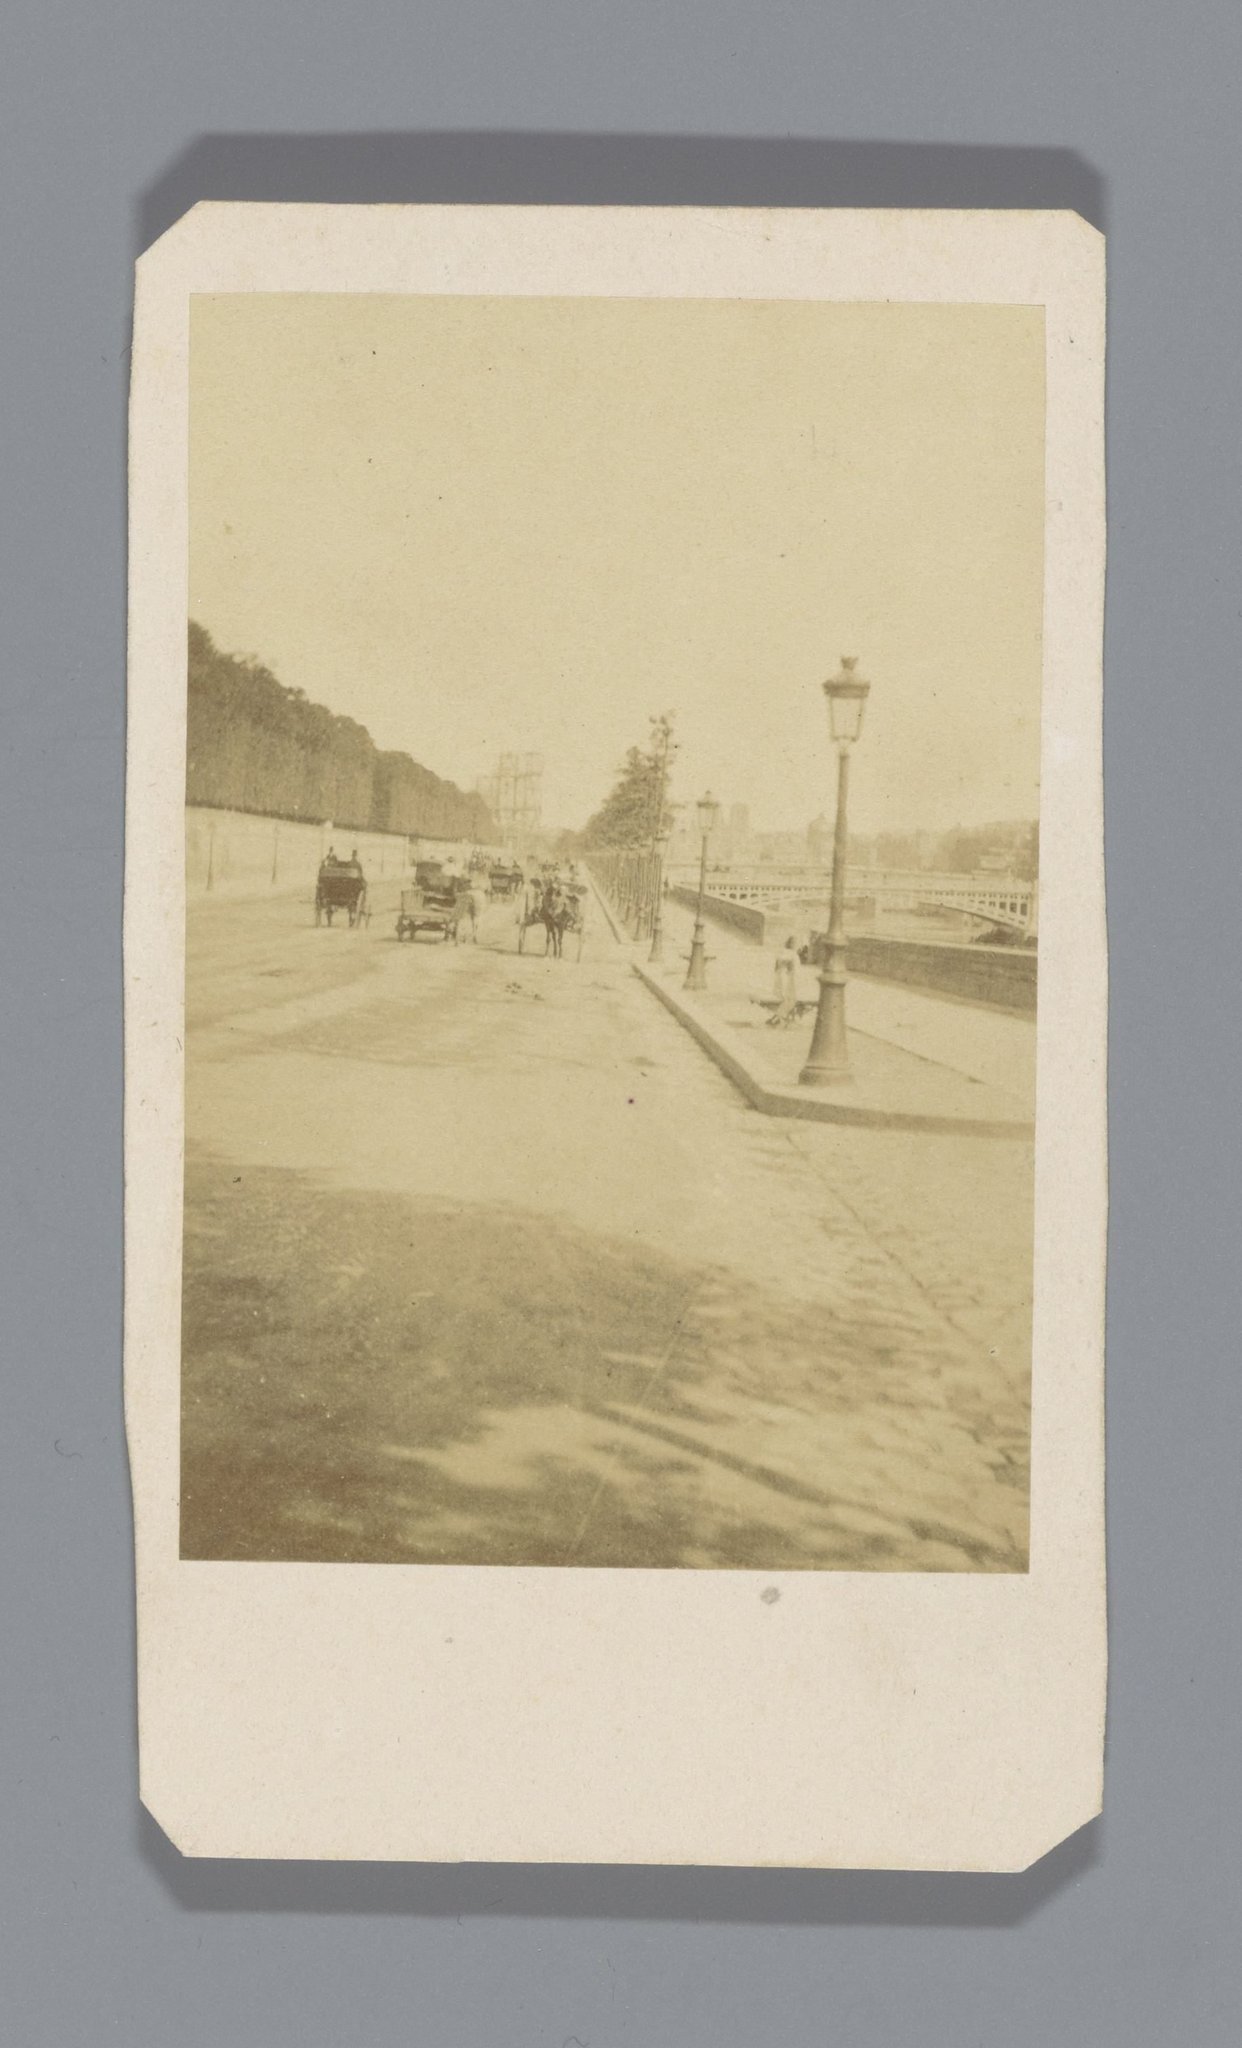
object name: photograph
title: Oever langs de Seine nabij de Pont Neuf, Parijs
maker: Anonymous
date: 1865-1870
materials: cardboard, paper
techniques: albumen print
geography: paris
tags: street (+ city(-scape) with figures, staffage)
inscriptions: inscription: ‘Sur le Pont Neuf/ Paris’